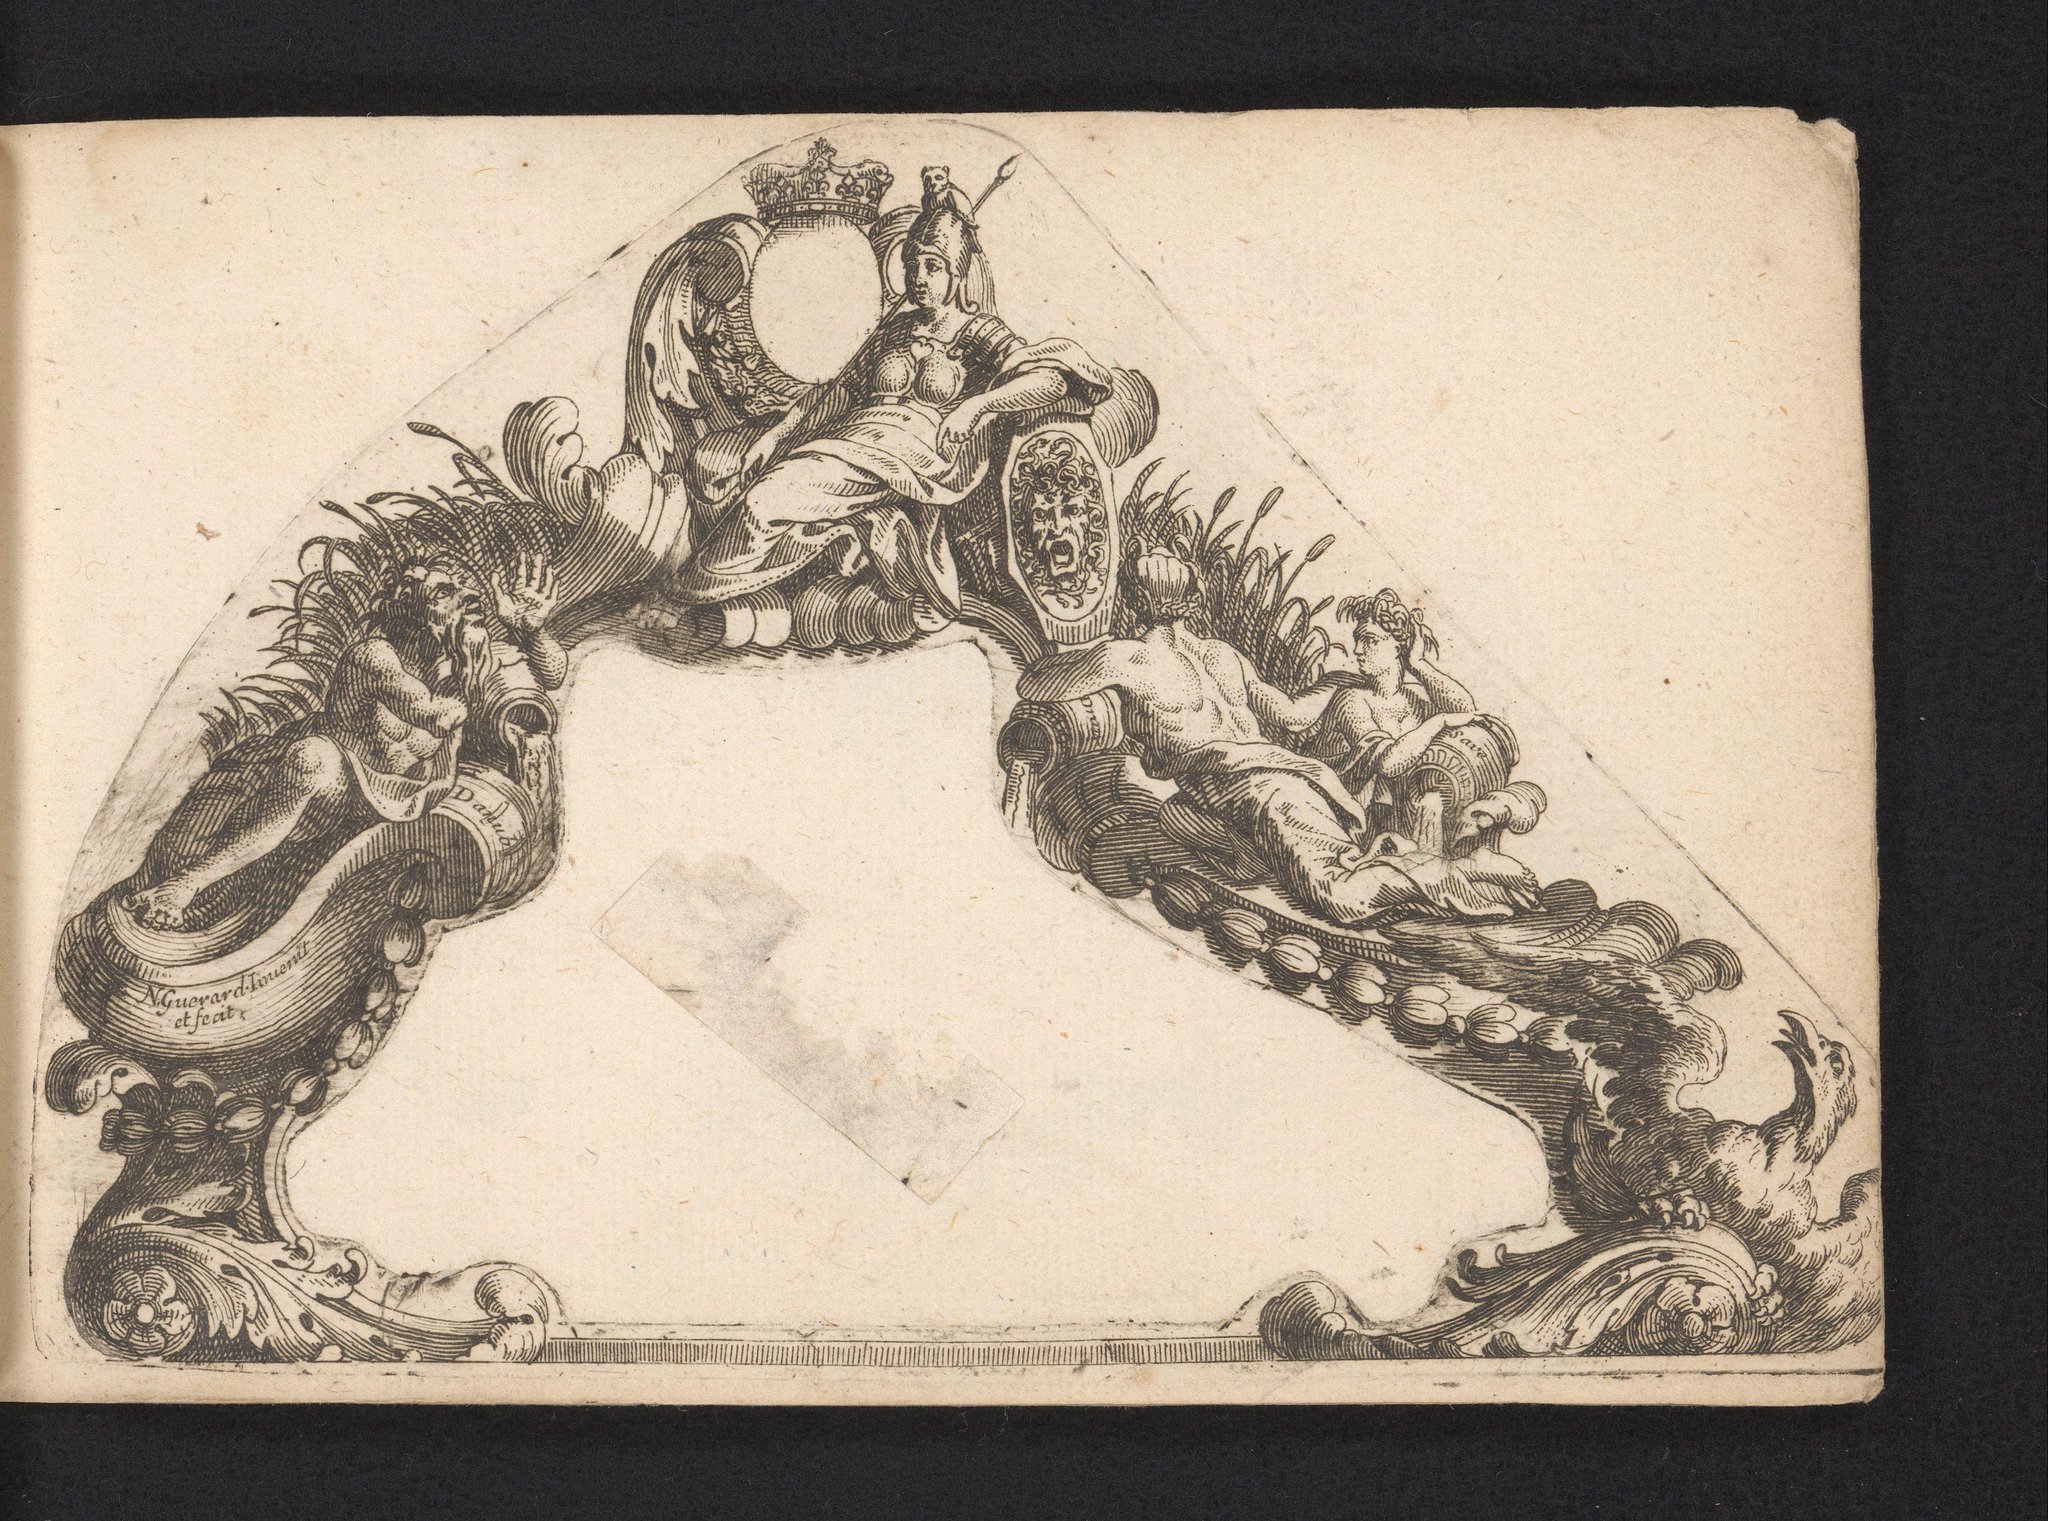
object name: album leaf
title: Omlijsting met Minerva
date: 1658-1719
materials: paper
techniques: etching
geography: paris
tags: predatory birds: eagle, (story of) minerva (pallas, athena), river personified, 'fiumi' (ripa), ornaments ~ art (+ framing decorations), personification of river danube; 'danubio' (ripa)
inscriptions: collector's mark: Lugt 2760, collector's mark: Lugt 2228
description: Een omlijsting met Minerva zitend bij een bekroond wapenschild, personificaties van de rivier de Donau en de Save en een adelaar. Prent maakt deel uit van een album met zes prenten van omlijstingen en cartouches.